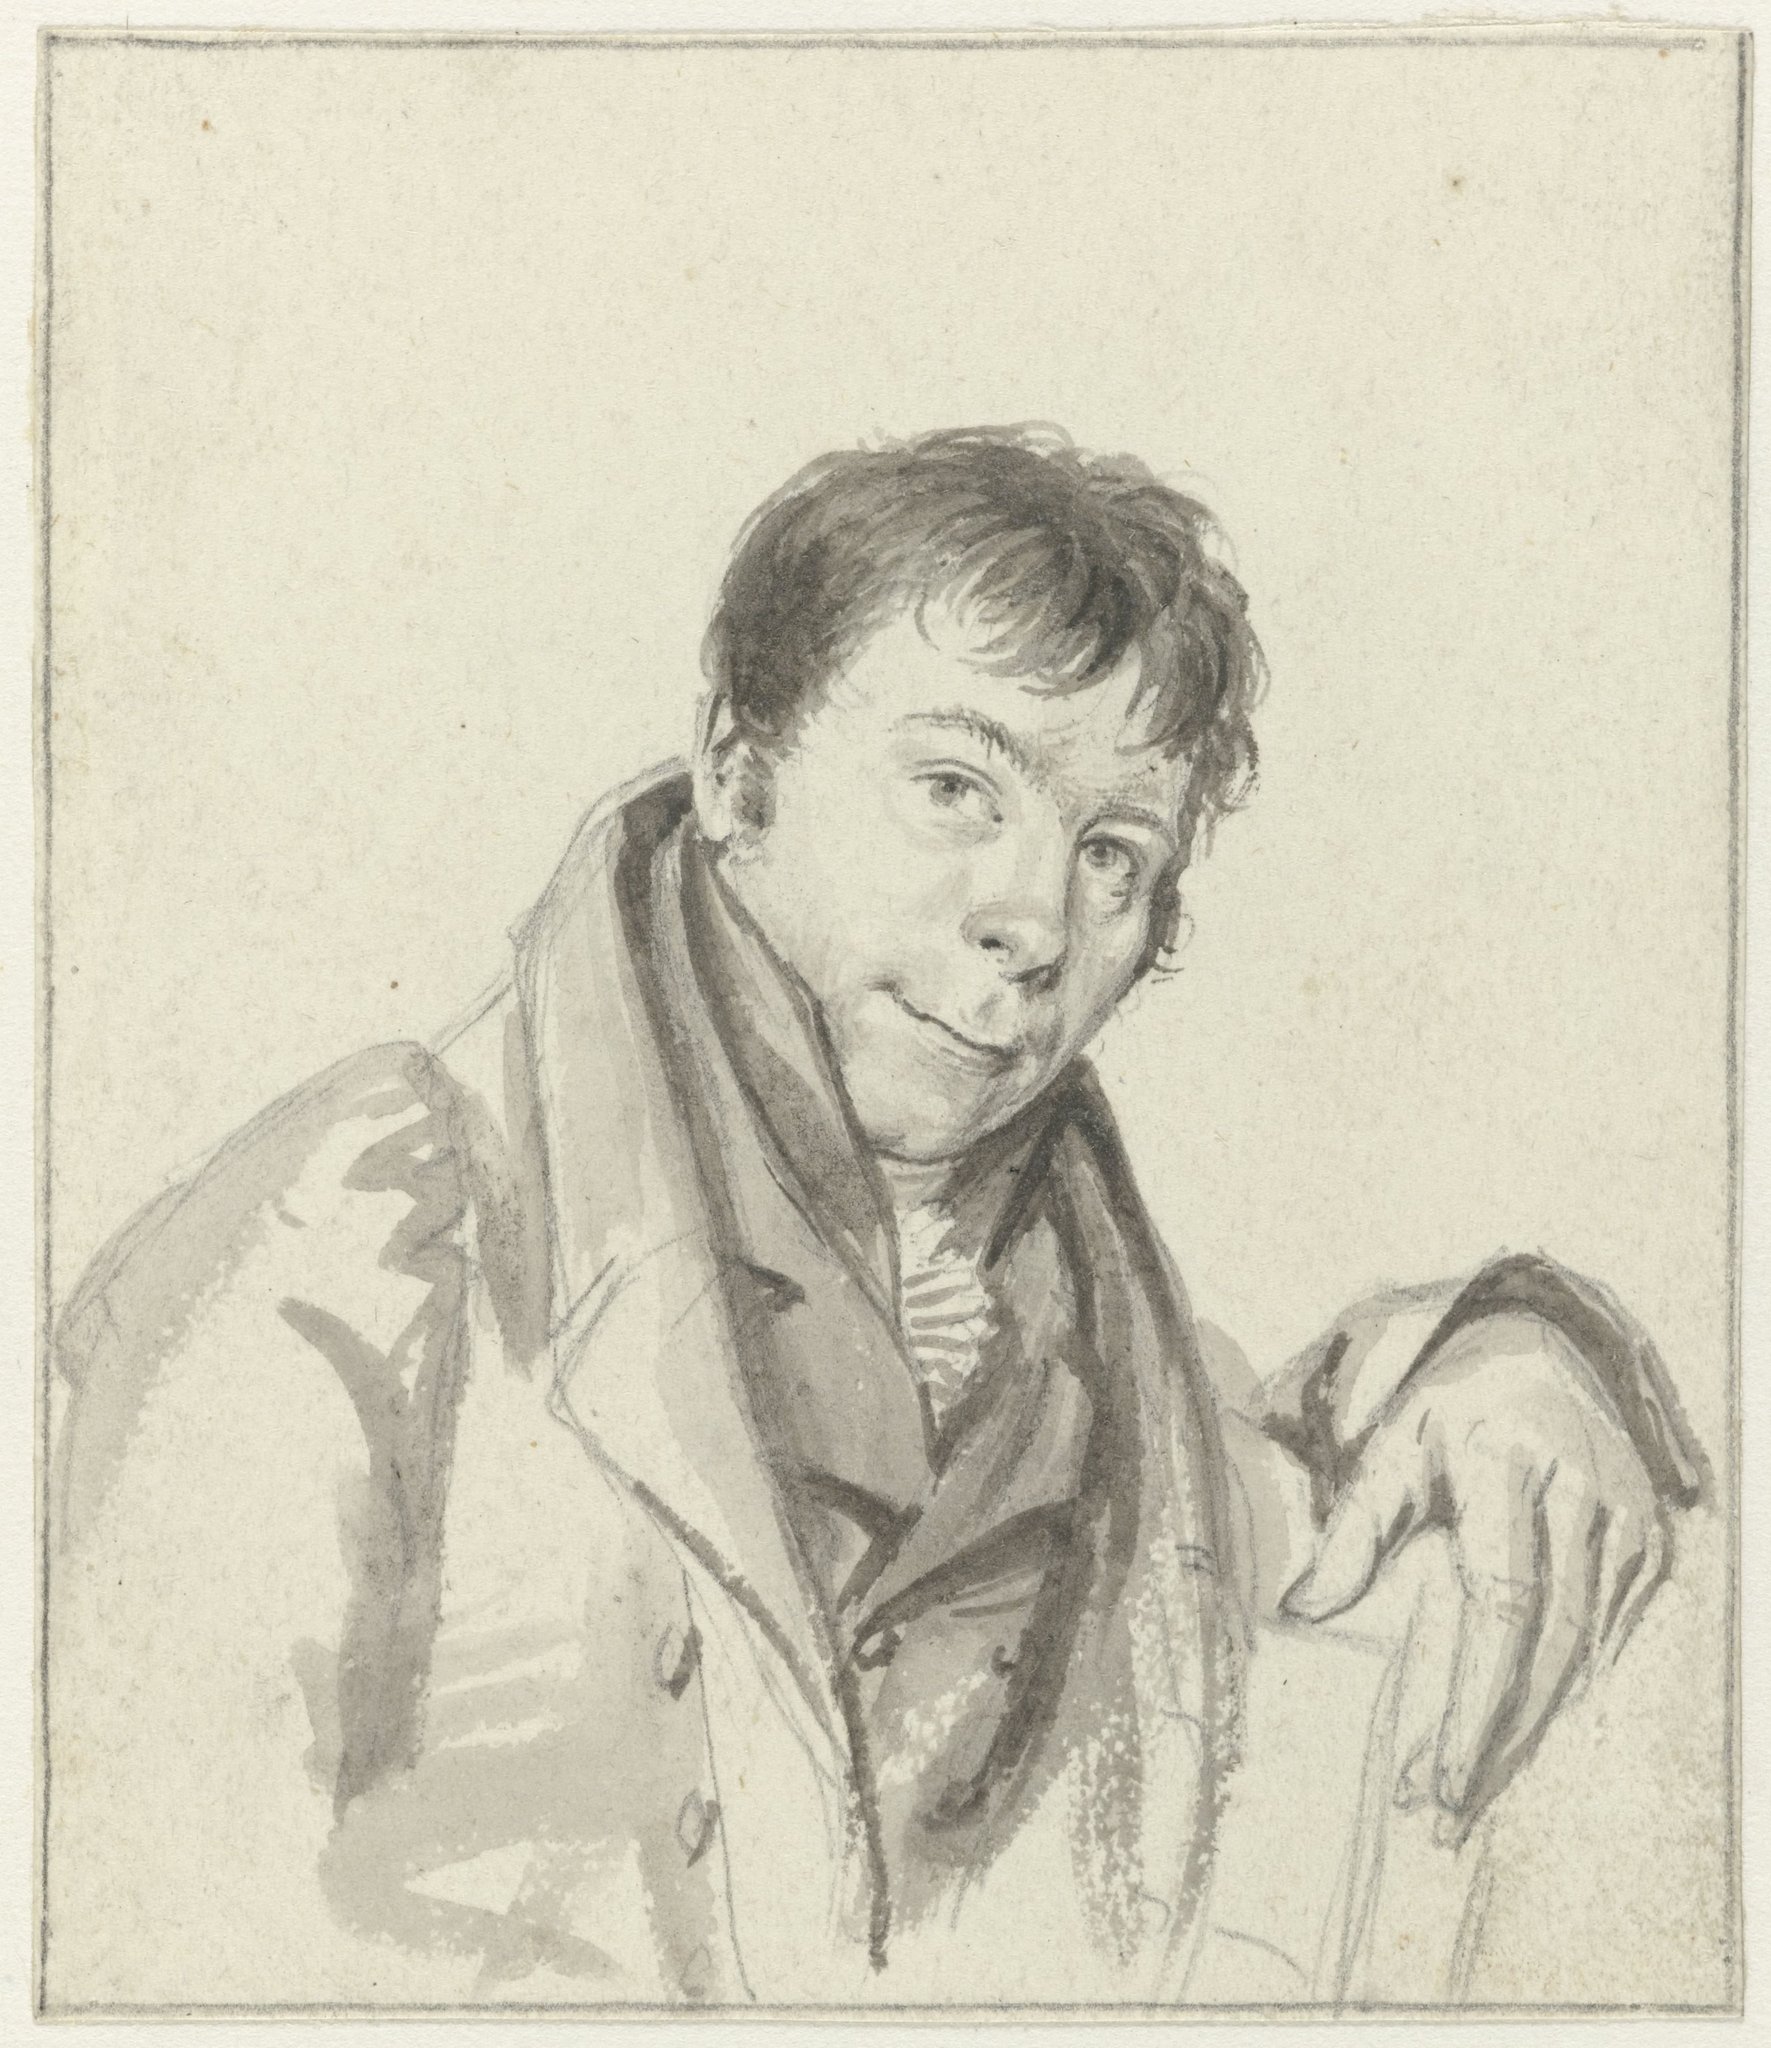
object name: drawing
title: Portret van Jacobus Wijsman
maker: hendrik willem caspari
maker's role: draughtsman, print maker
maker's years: 1770-1829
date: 1780-1829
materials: ink, paper, pencil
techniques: pen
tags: sloterdijk, jacobus wijsman, historical persons, portrait, self-portrait of artist, portrait, self-portrait of graphic artist